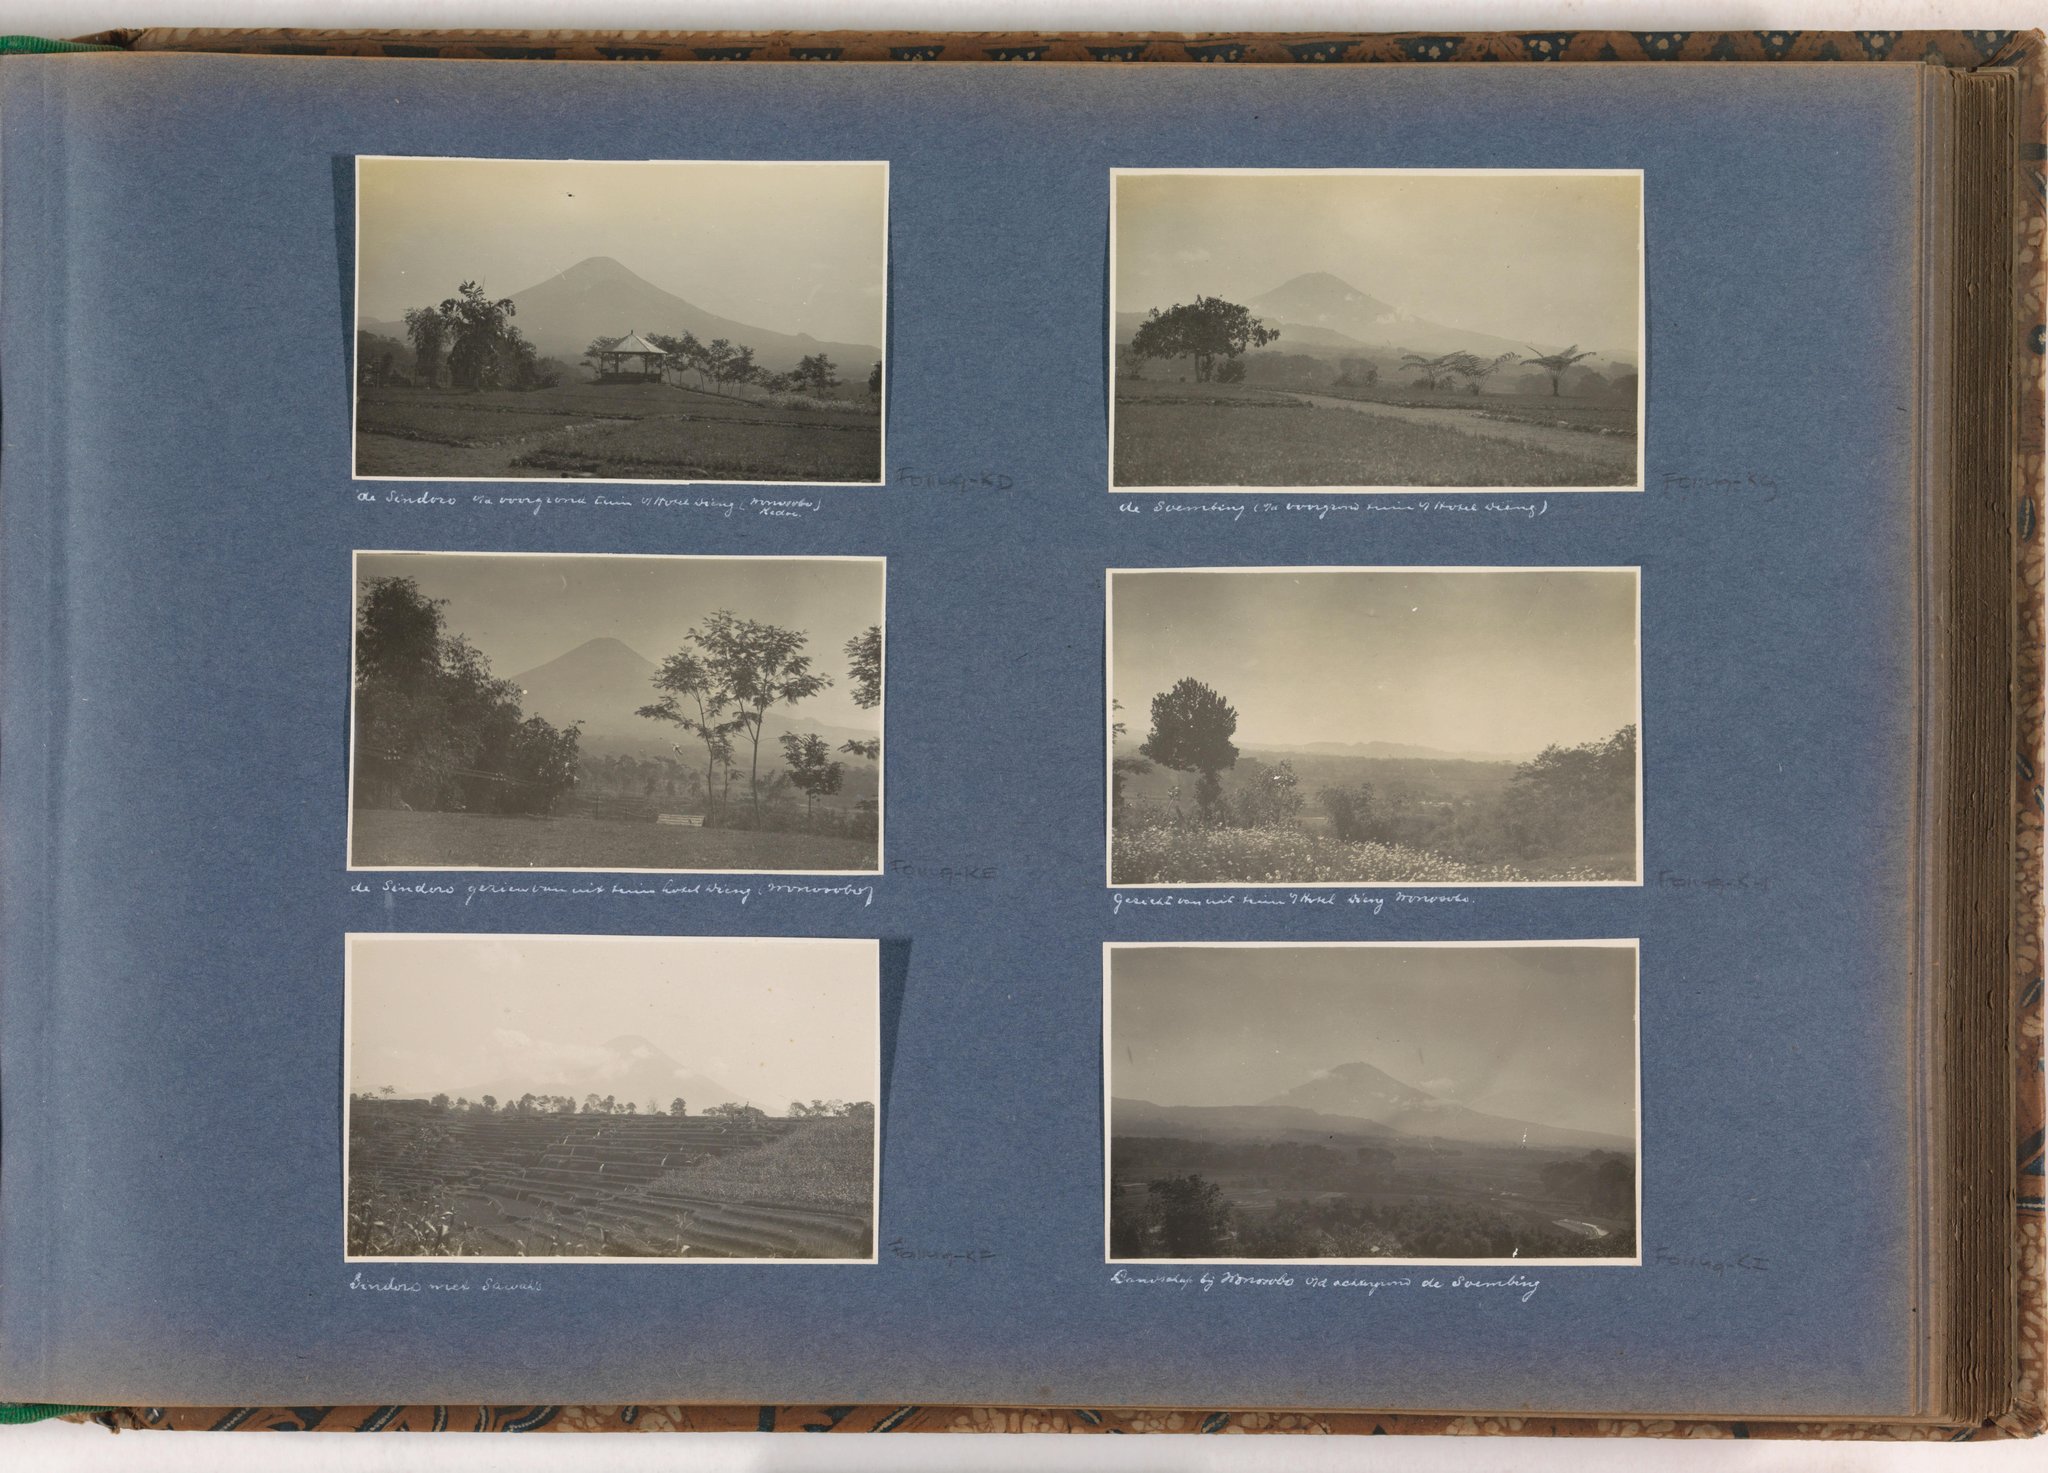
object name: photograph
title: Landschap op Java met op de achtergrond de vulkaan Sumbing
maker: Anonymous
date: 1900-1920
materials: paper, photographic support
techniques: gelatin silver print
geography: java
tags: volcano, mountains (in tropical and sub-tropical regions), java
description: Onderdeel van reisalbum met foto's van bedrijvigheid en bezienswaardigheden op Sumatra en Java en van de reis naar en van Nederlands-Indië.